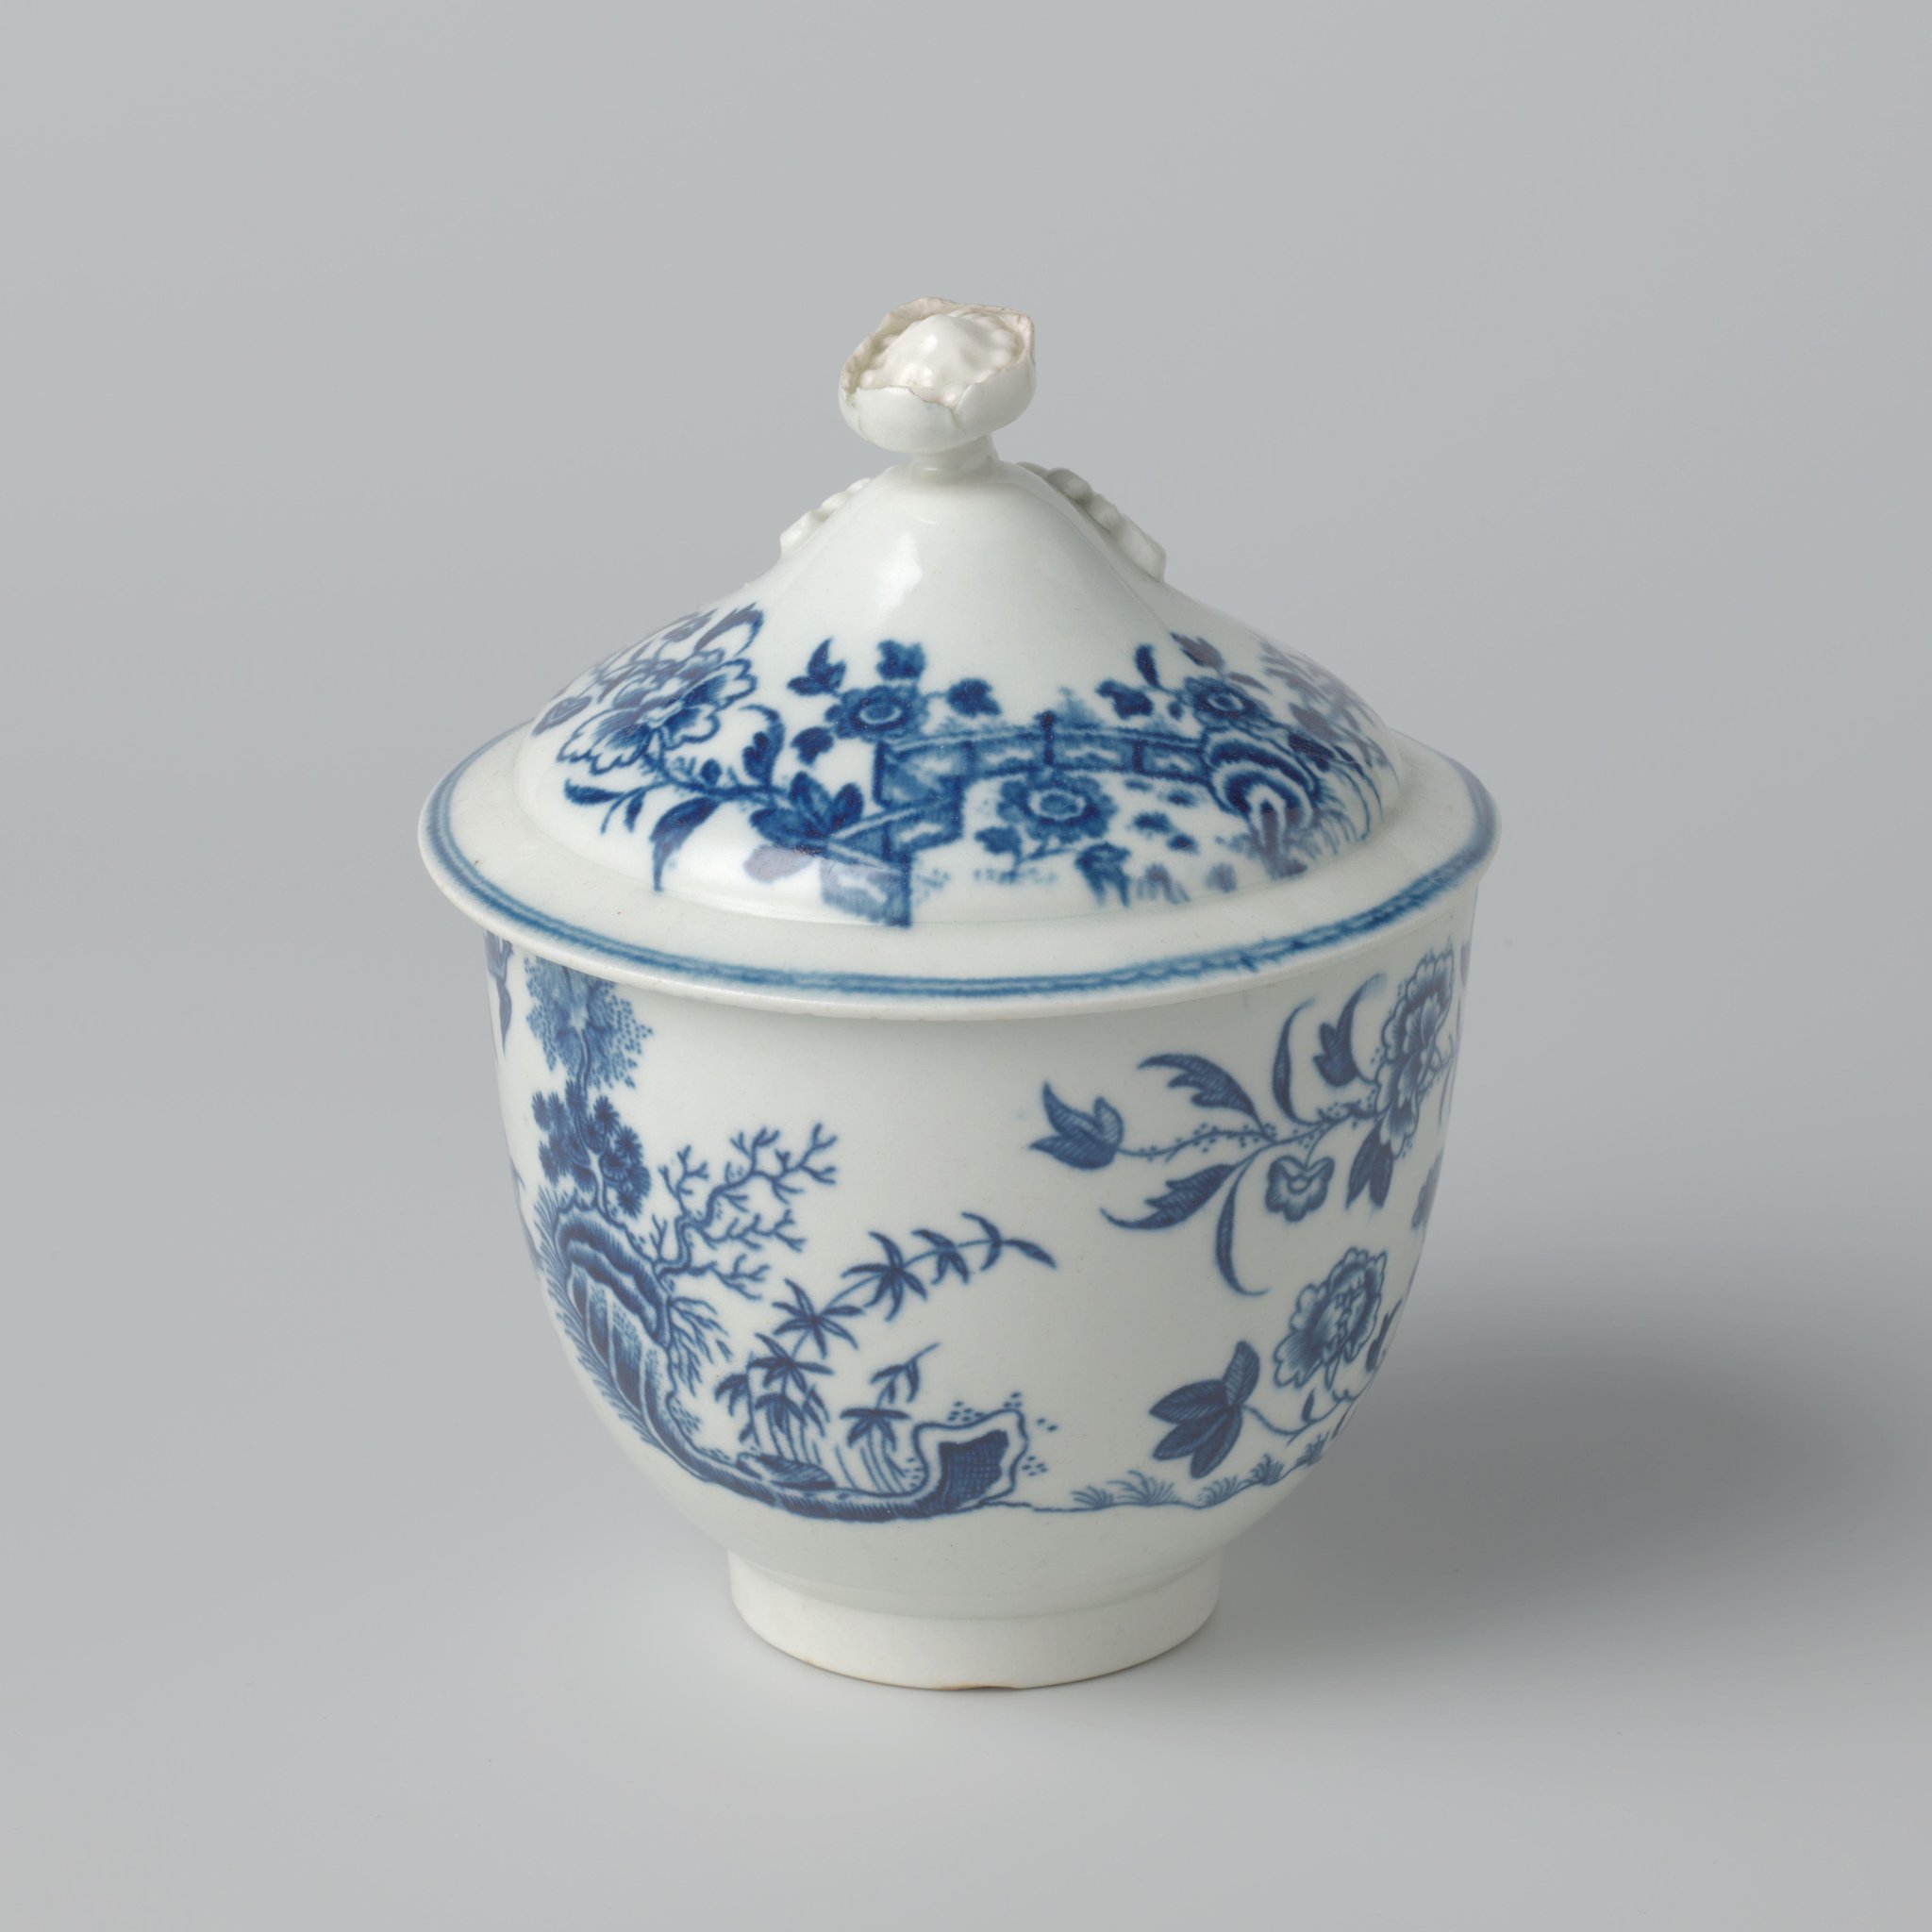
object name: sugar box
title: Suikerpot van Worcester-porselein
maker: Anonymous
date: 1800-1900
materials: porcelain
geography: worcester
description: Suikerpot van Worcester-porselein. De ronde witte suikerpot is in blauw bedrukt met een hekwerk, planten, bloemen, bomen en twee vliegende vogels in Chinese trant. Gemerkt met een geschaduwde halve maan in blauw.